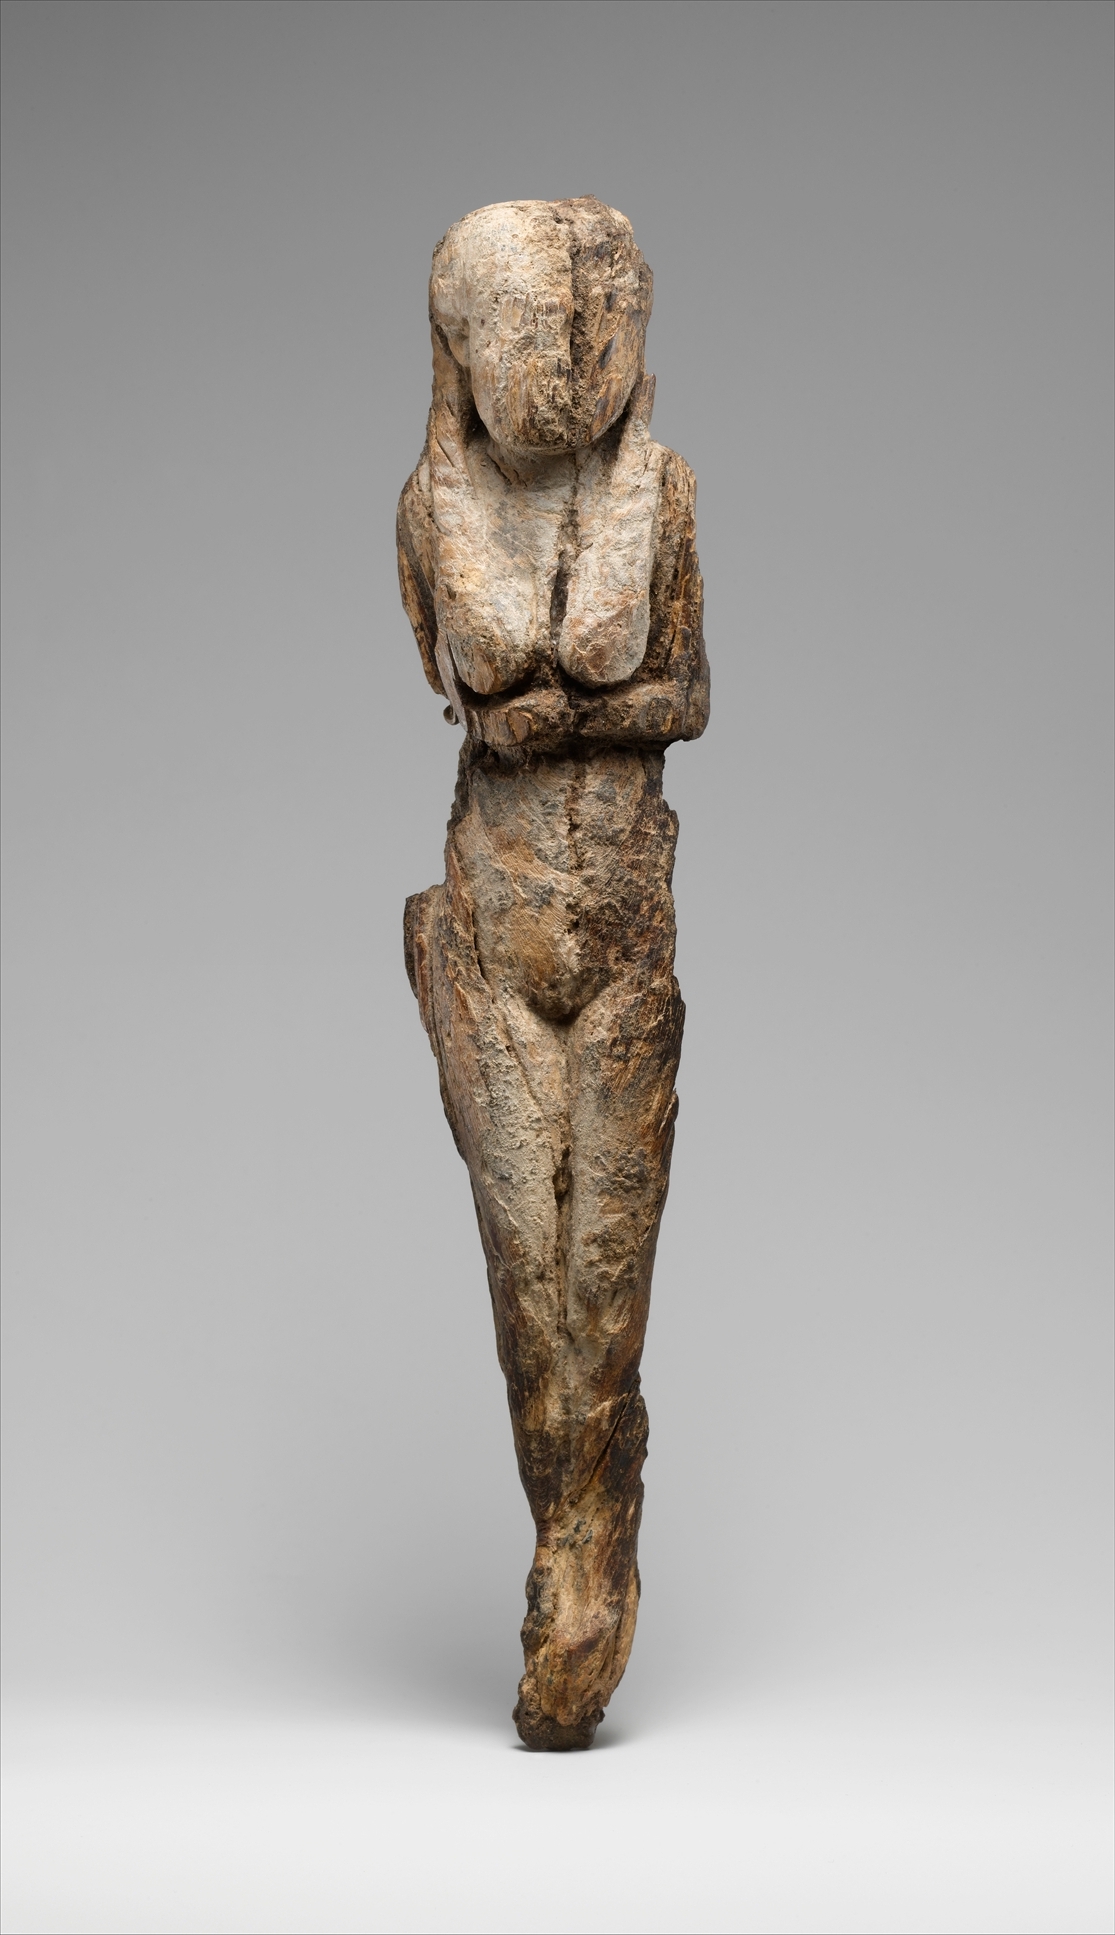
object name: statuette of a woman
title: Statuette of a Standing Woman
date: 3100-2900 BCE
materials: ivory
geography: egypt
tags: female nudes